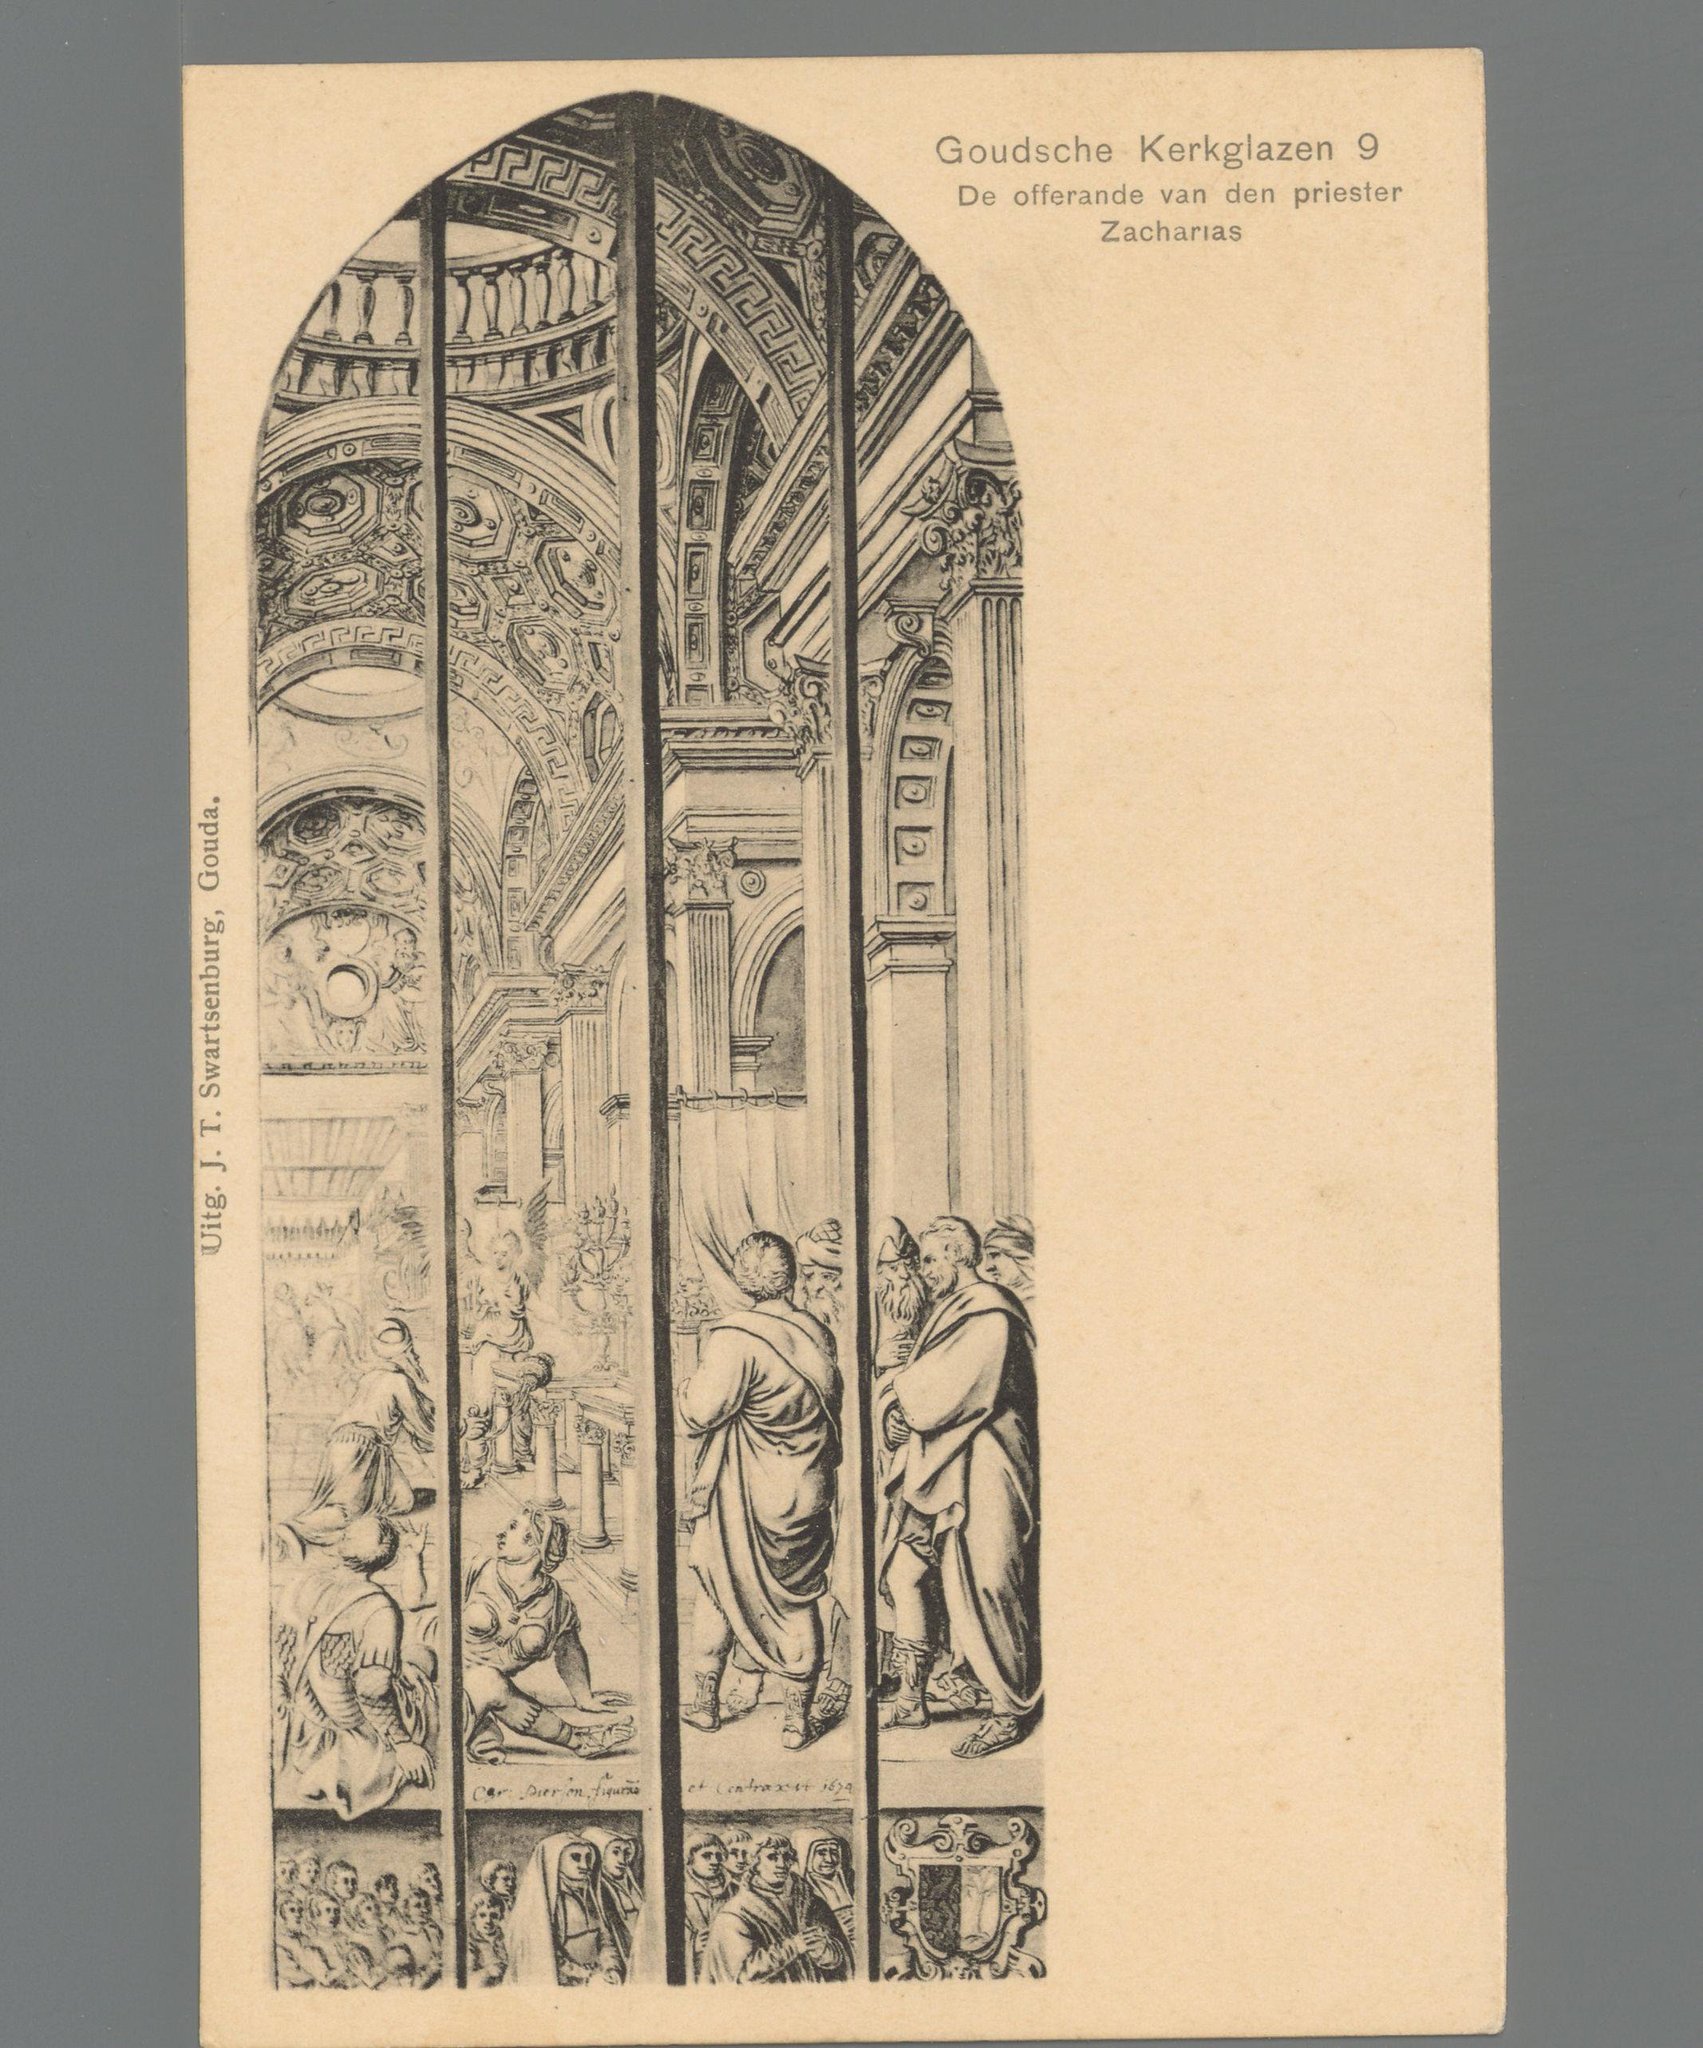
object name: photomechanical print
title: Goudsche Kerkglazen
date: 1892-1905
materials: cardboard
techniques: photograph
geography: gouda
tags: church-window, e.g. rose-window, annunciation of the birth of john the baptist to zacharias: while he is offering incense in the temple an angel (gabriel) appears to him, gouda